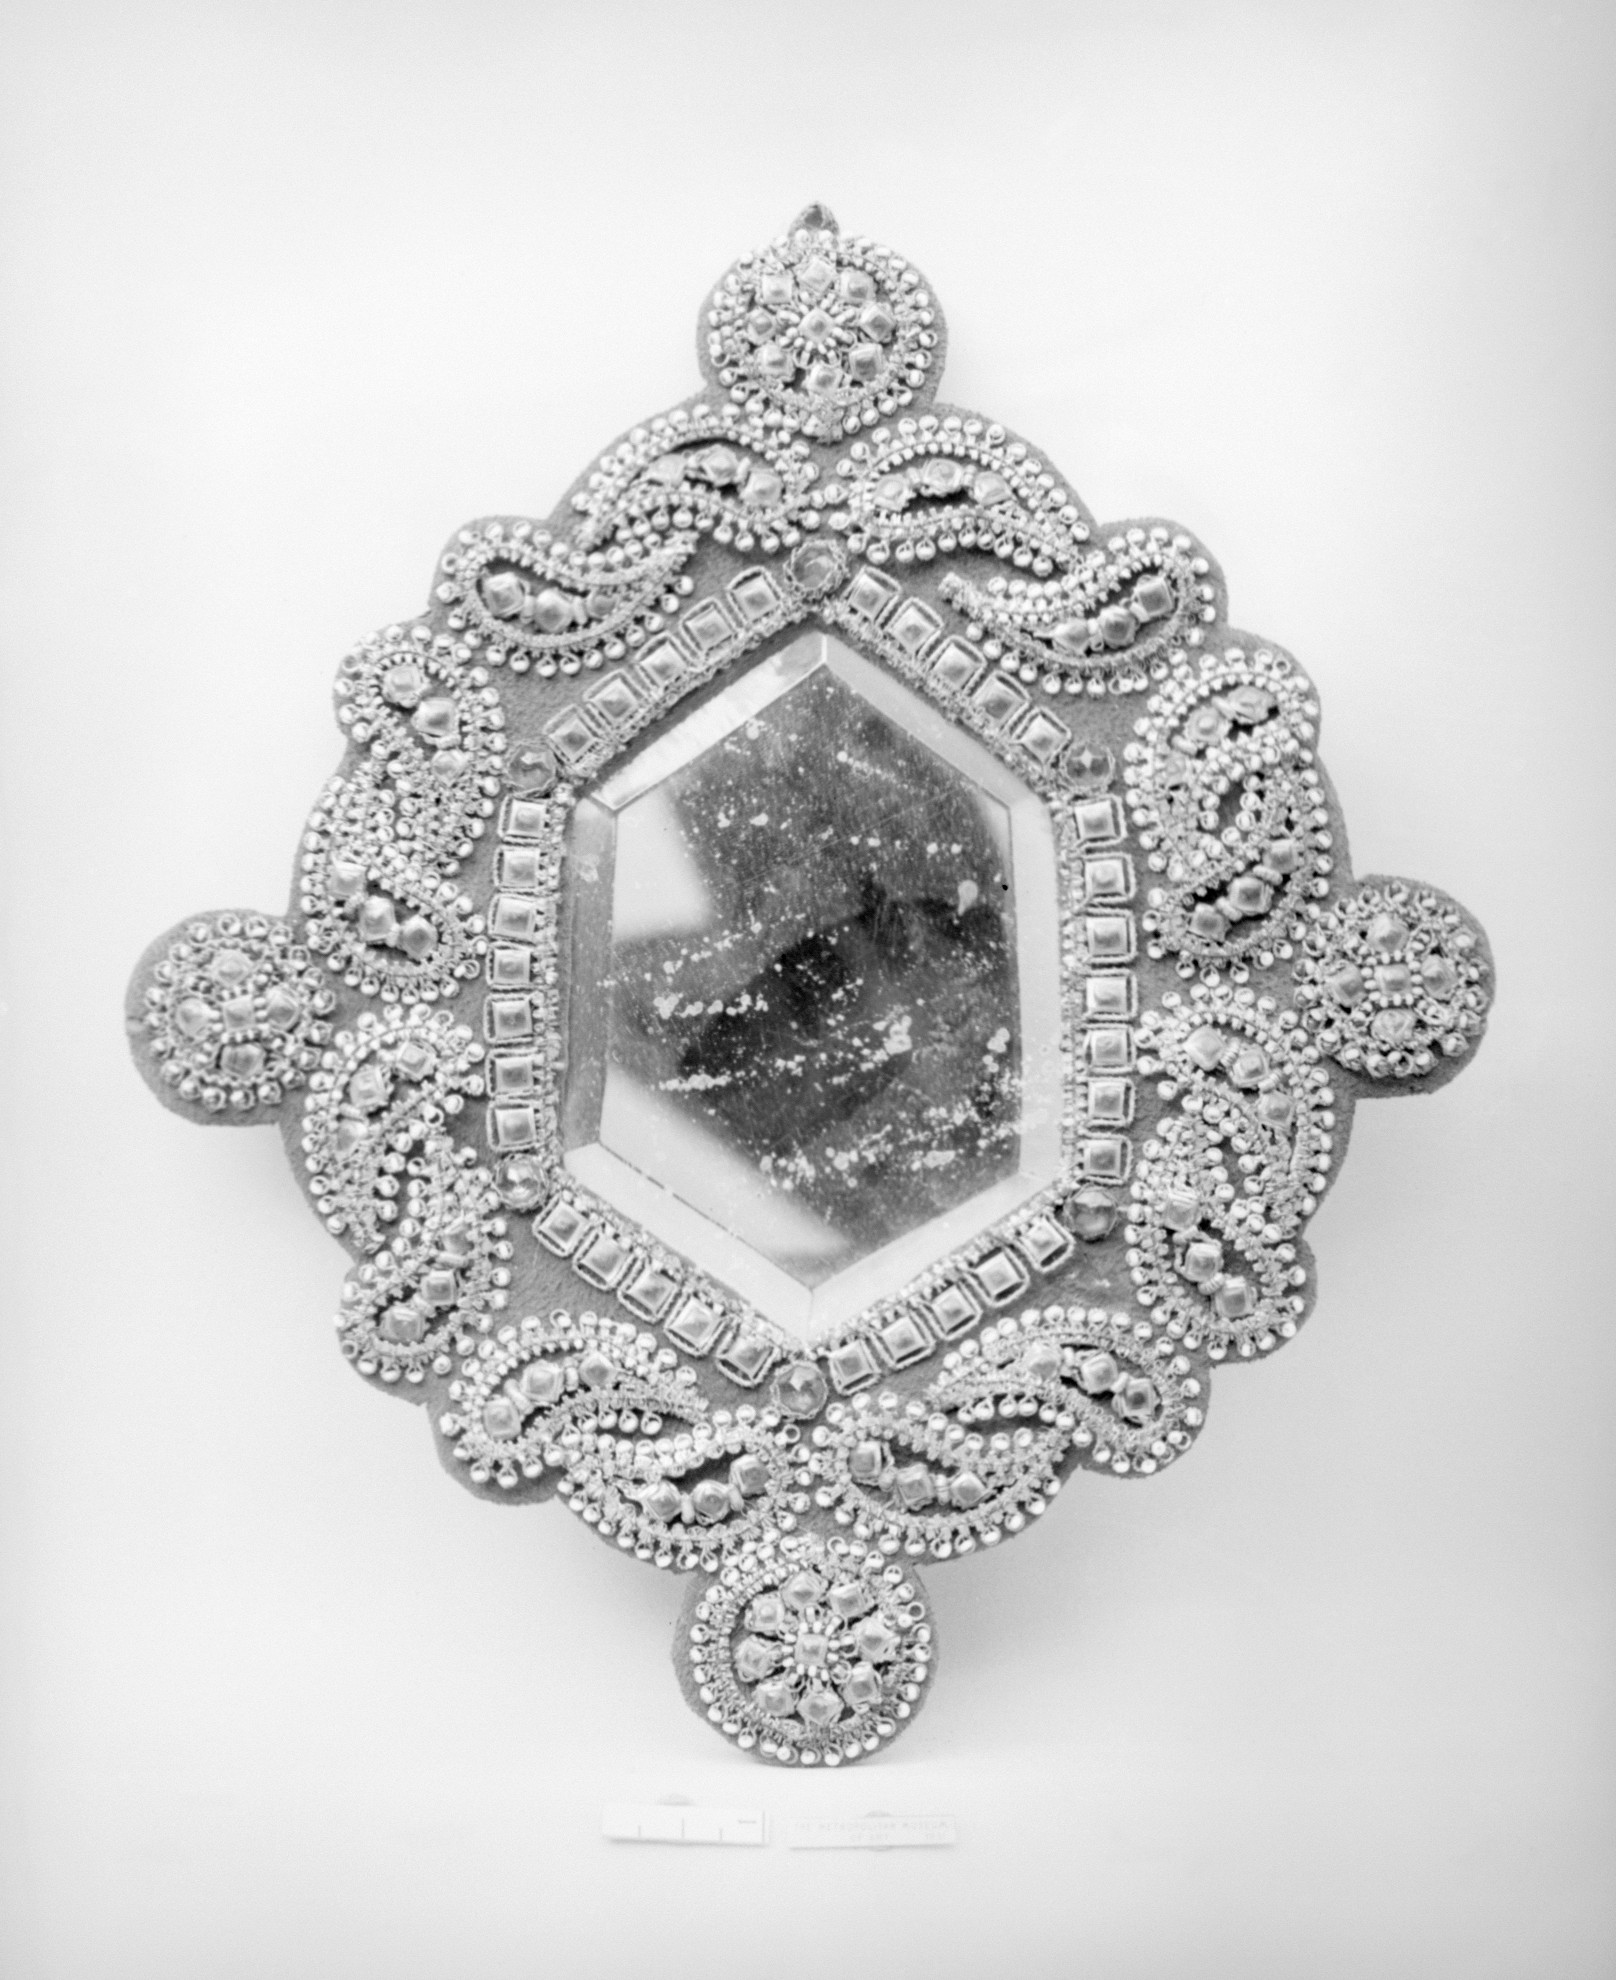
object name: mirror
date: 1601-1700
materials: leather